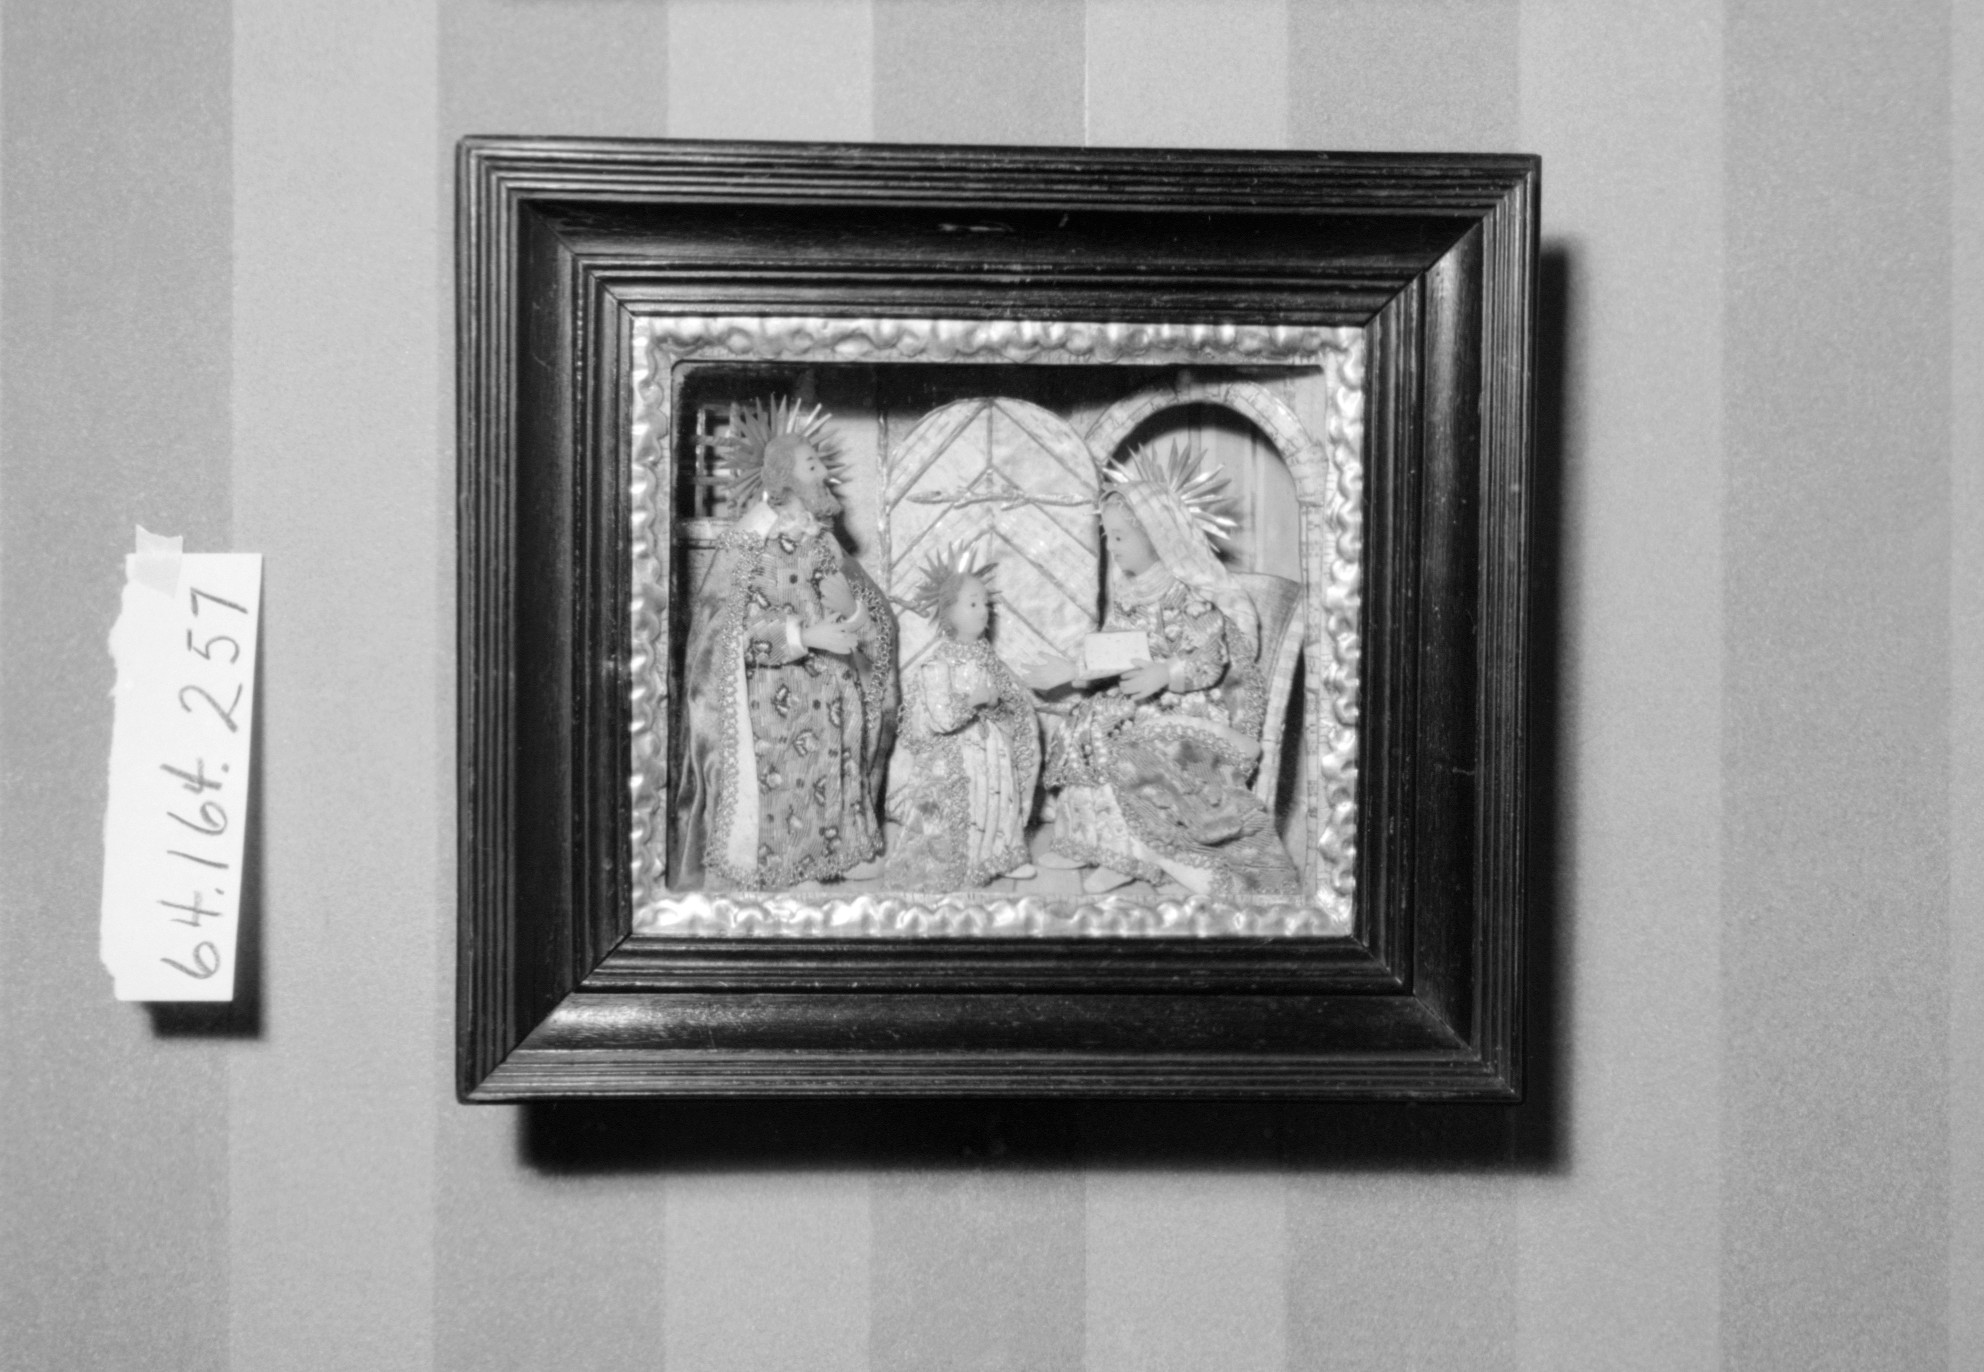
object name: sculpture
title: Holy Family in the Workshop of St. Joseph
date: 1801-1900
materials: foil, glass, linen, paper, silk, silver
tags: infants,men,women,holy family